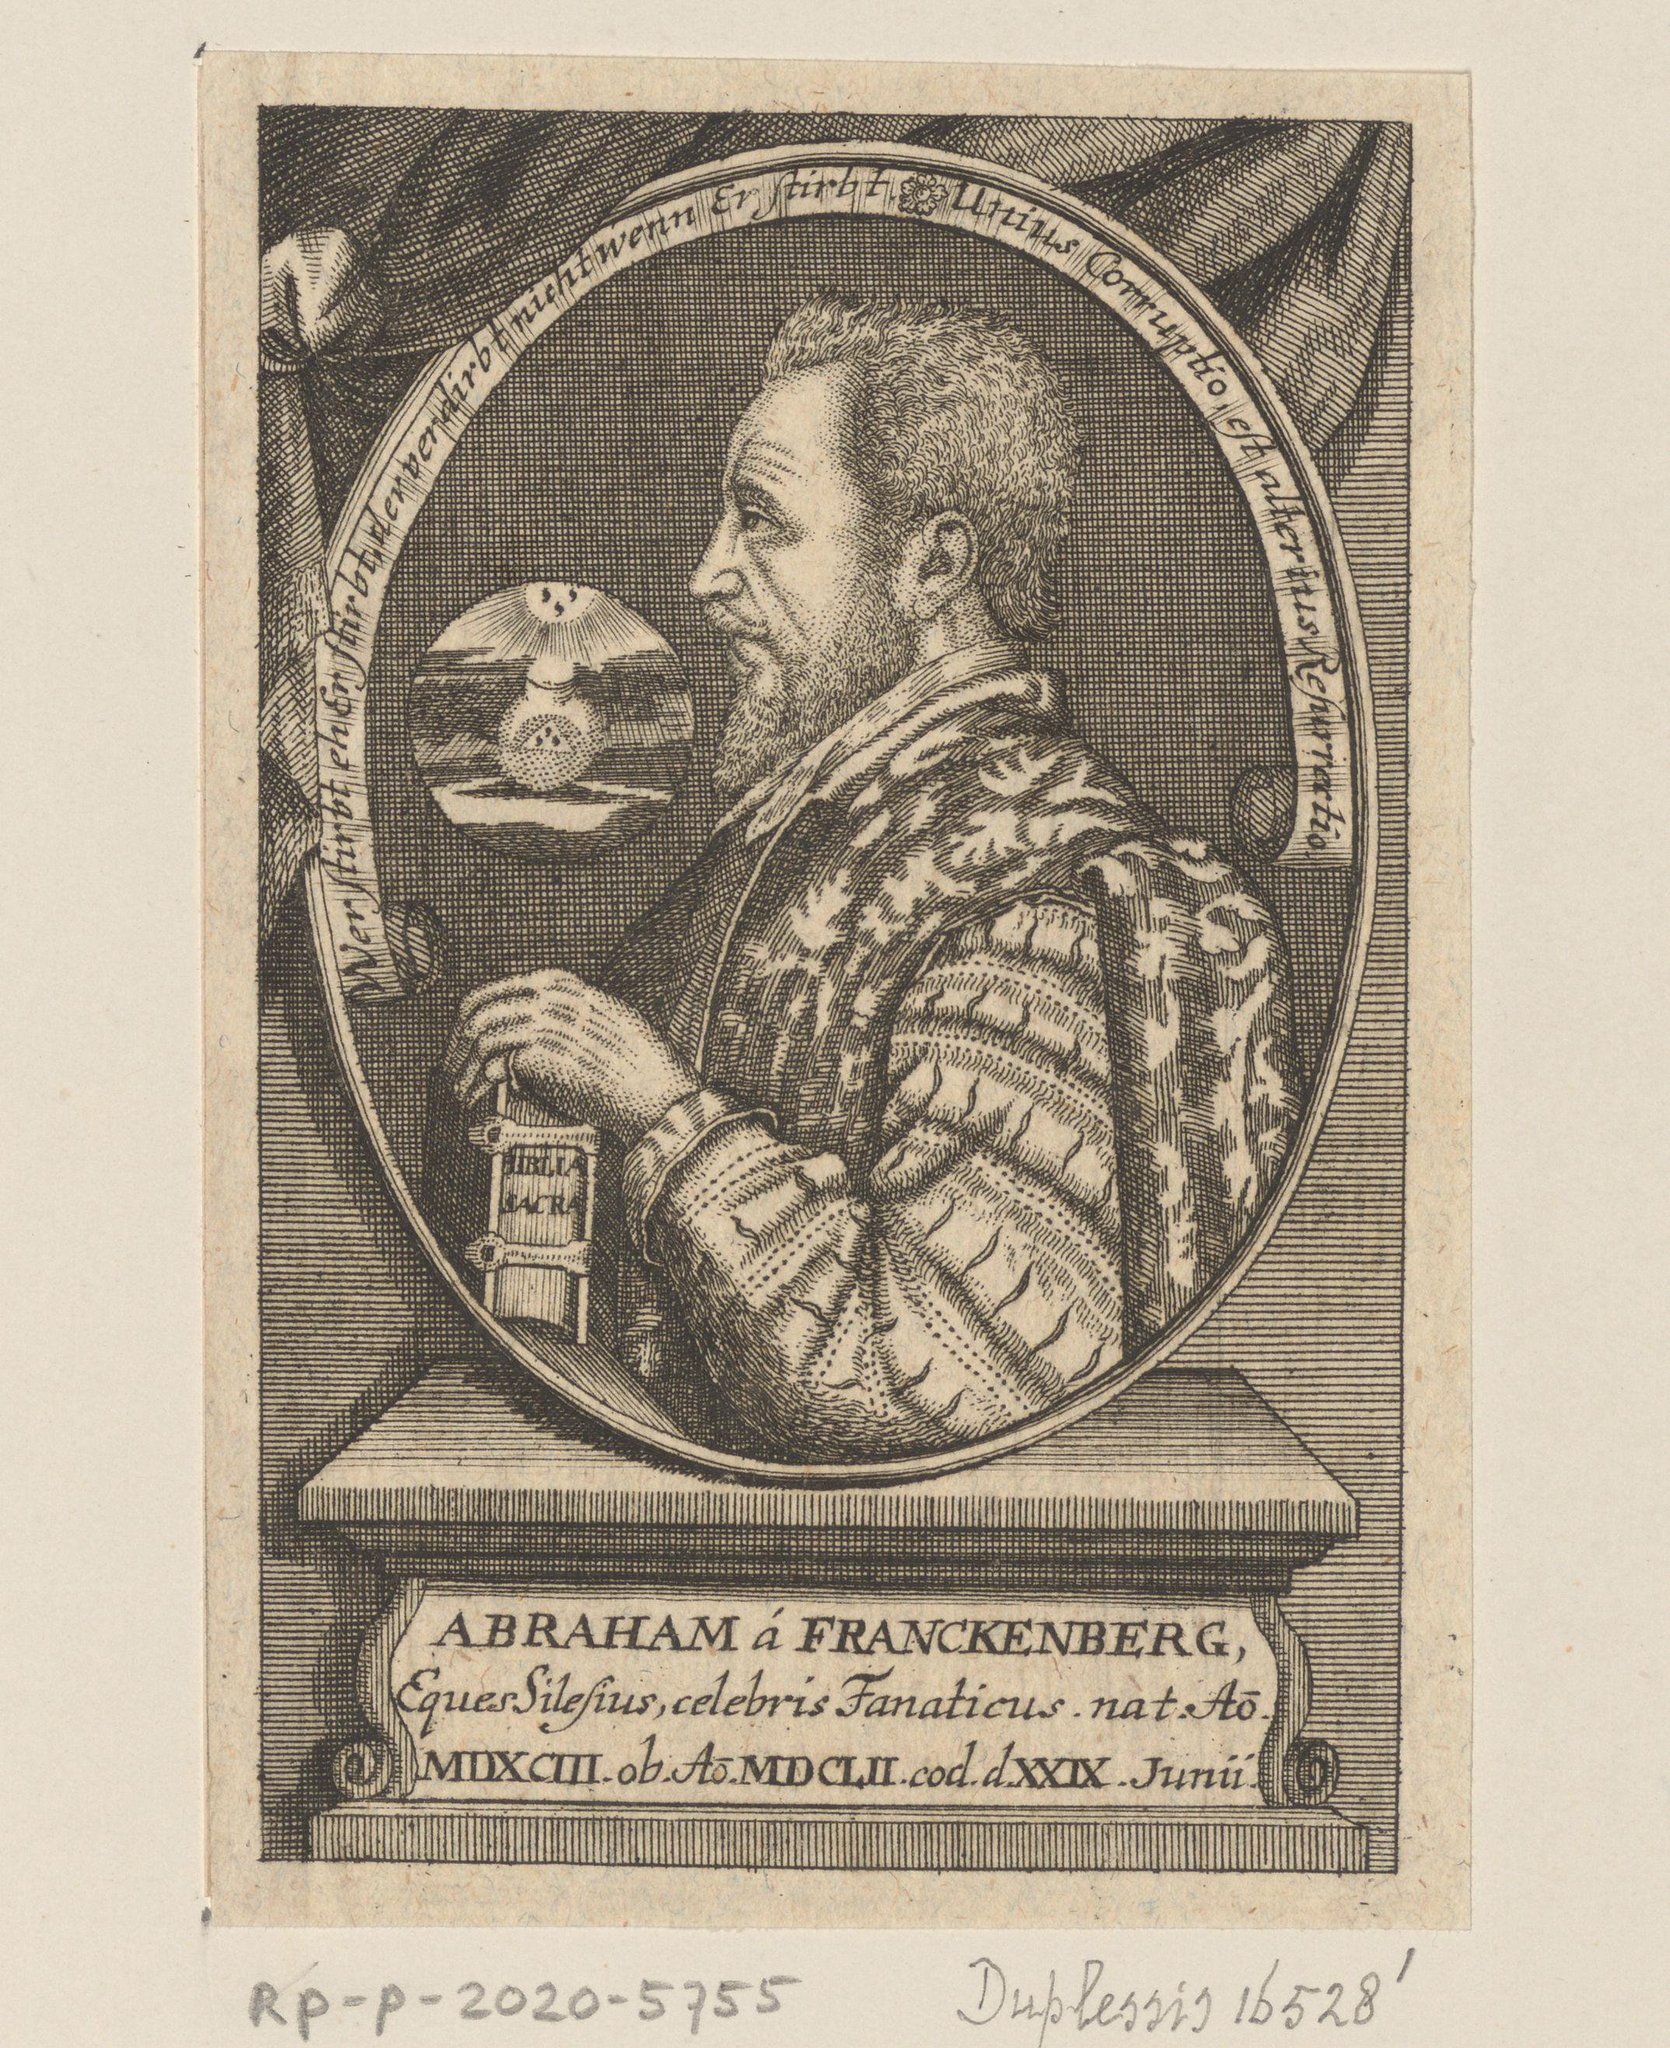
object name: print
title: Portret van Abraham von Franckenberg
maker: Anonymous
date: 1725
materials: paper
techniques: etching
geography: germany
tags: representations of the trinity, (feigned) picture curtain, ornament ~ medallion, historical persons, the bible as a book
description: Prent waarschijnlijk uit: Fortgesetzte Sammlung von Alten und Neuen Theologischen Sachen (...) auff das Jahr 1725. Leipzig: erven Johann Friedrich Brauns, 1725.